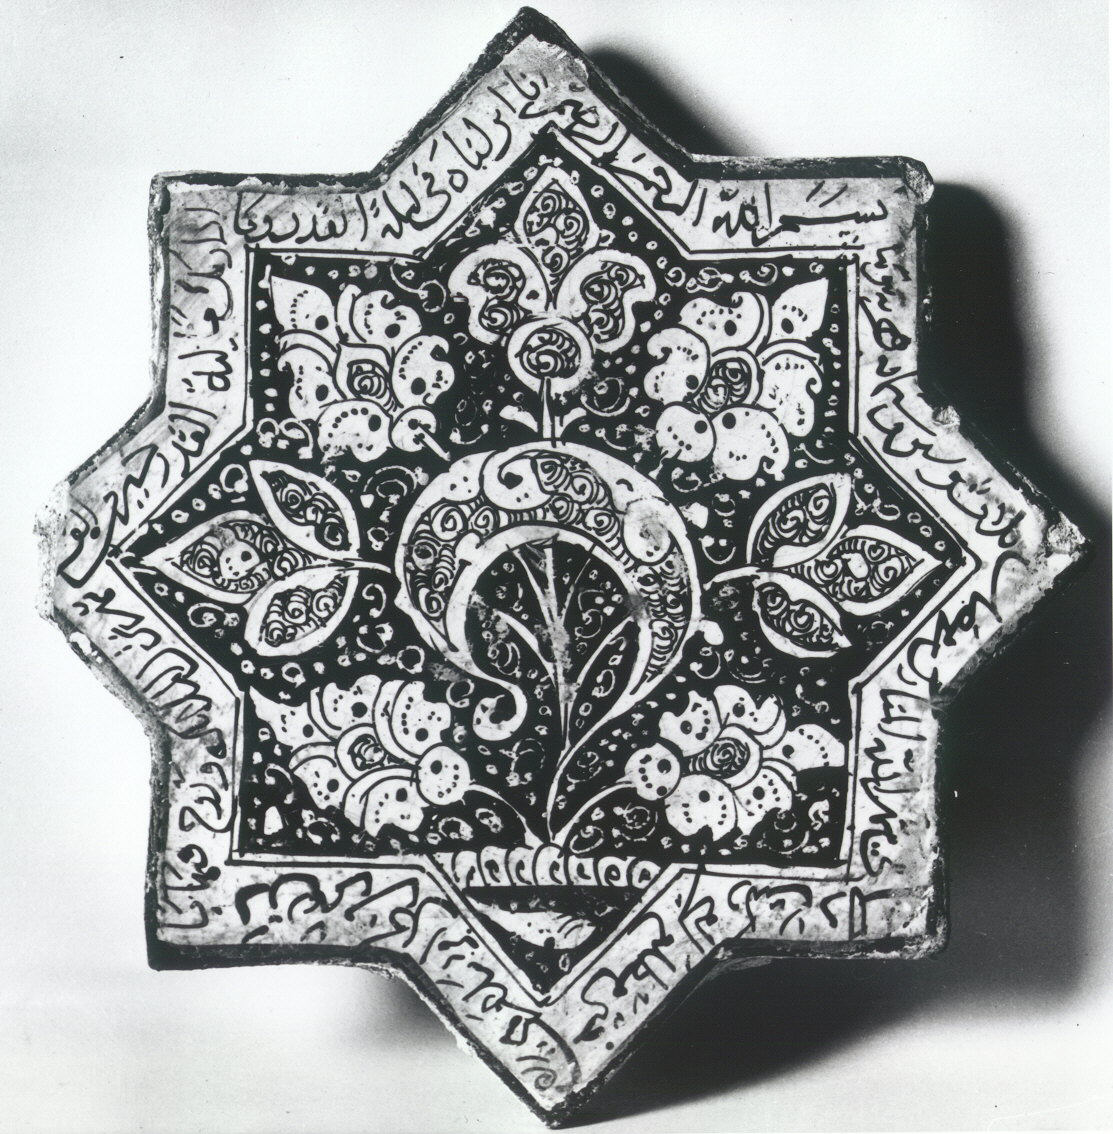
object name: tile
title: Star-Shaped Tile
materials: cobalt, glaze, stonepaste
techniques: luster painting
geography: iran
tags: arabic,flowers